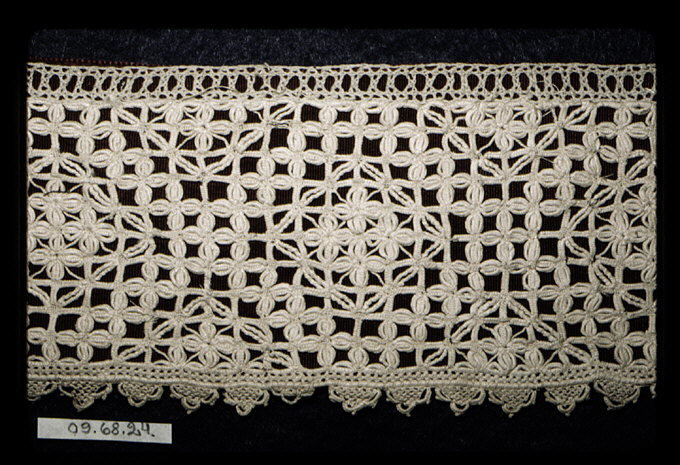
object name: border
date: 1600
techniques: lace